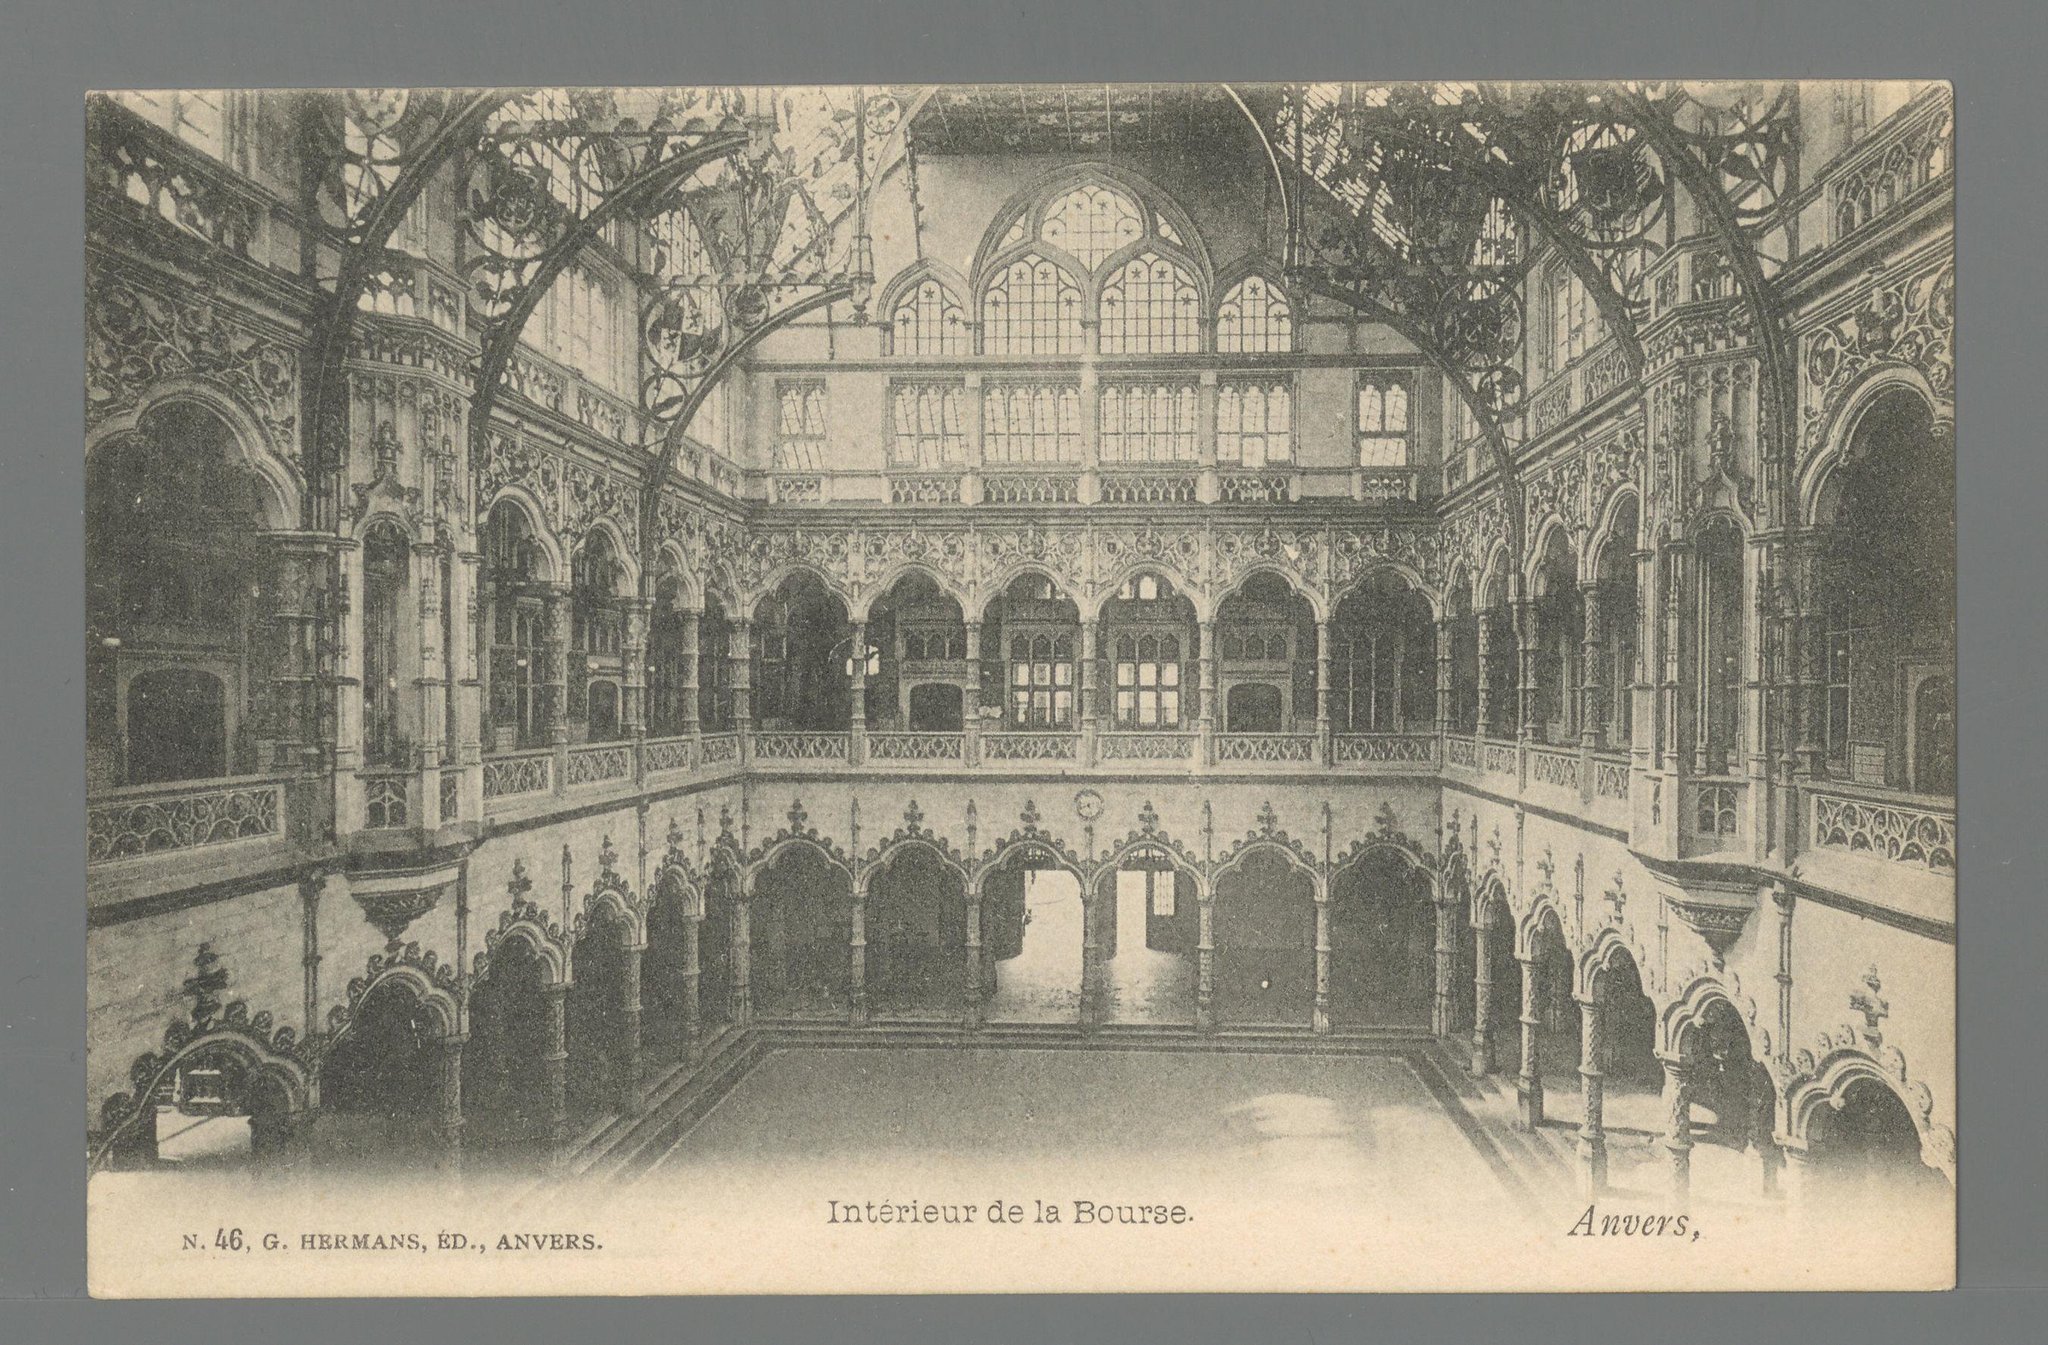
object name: ansichtkaart, prentbriefkaart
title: Intérieur de la Bourse. Anvers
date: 1892-1906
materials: cardboard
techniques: photograph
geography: antwerp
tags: interior ~ representation of a building, exchange, bourse